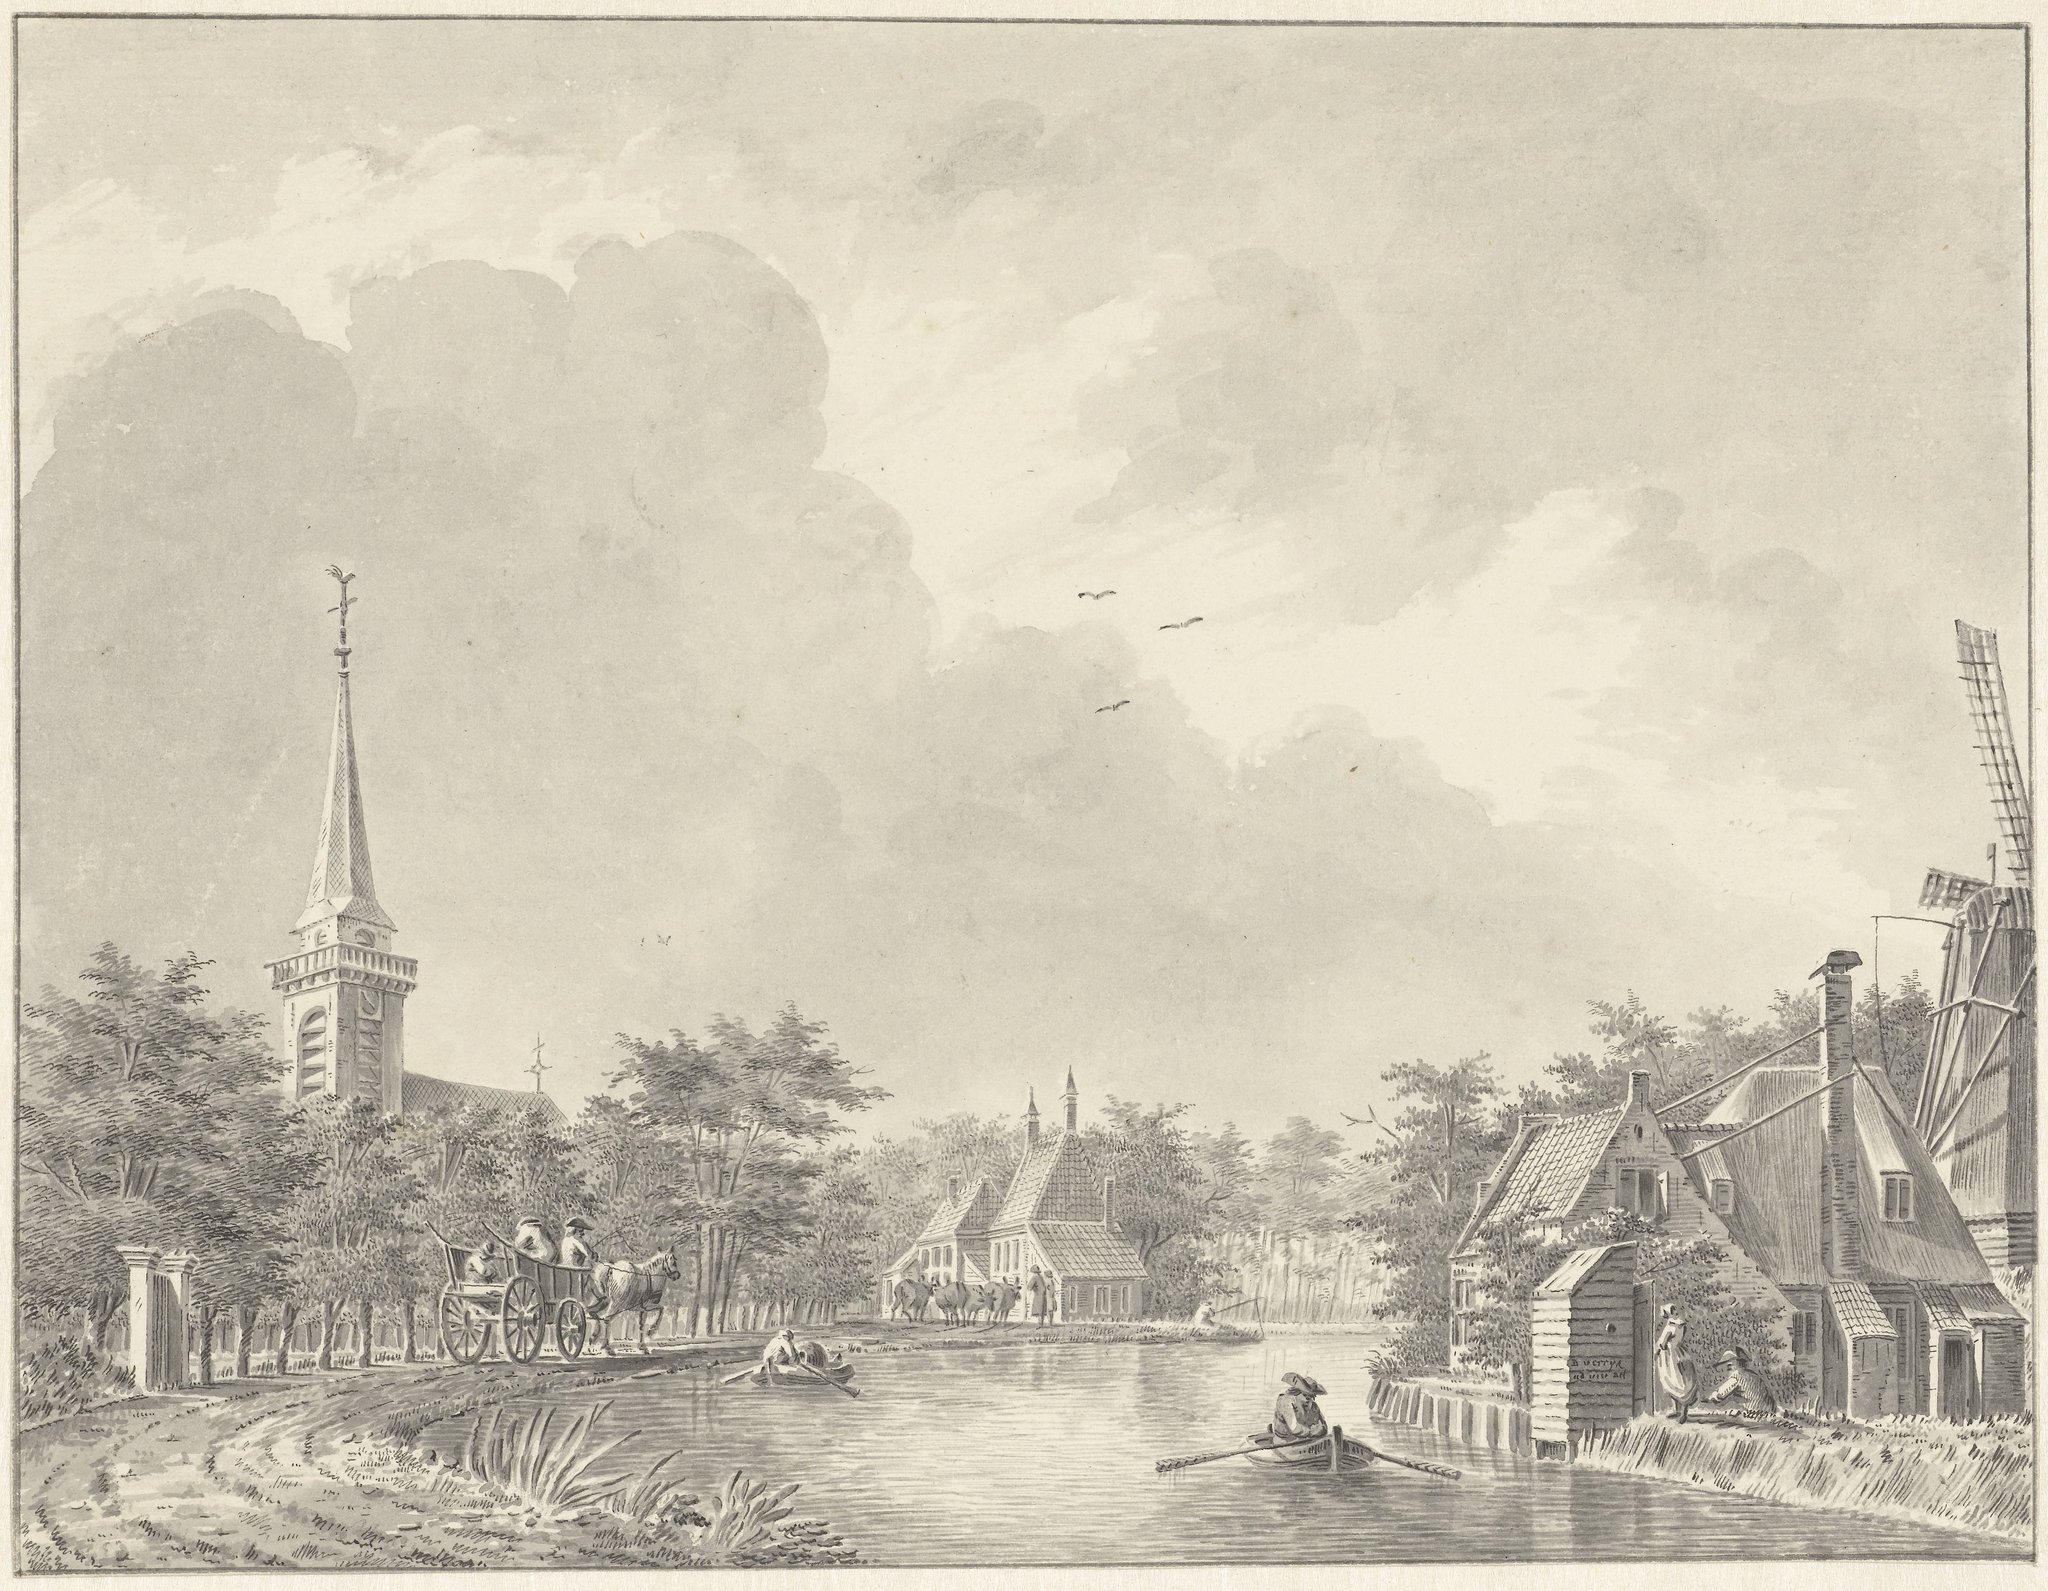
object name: drawing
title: Het dorp Harmelen aan de Leidse Vaart buiten Utrecht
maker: dirk verrijk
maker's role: draughtsman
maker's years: 1734-1786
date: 1744-1786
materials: ink, paper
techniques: brush, pen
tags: village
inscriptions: inscription: ‘'t Dorp Harmelen 2 uuren van de Stad Utrecht / aan de Leidse Vaart / D Verryk ad viv del’